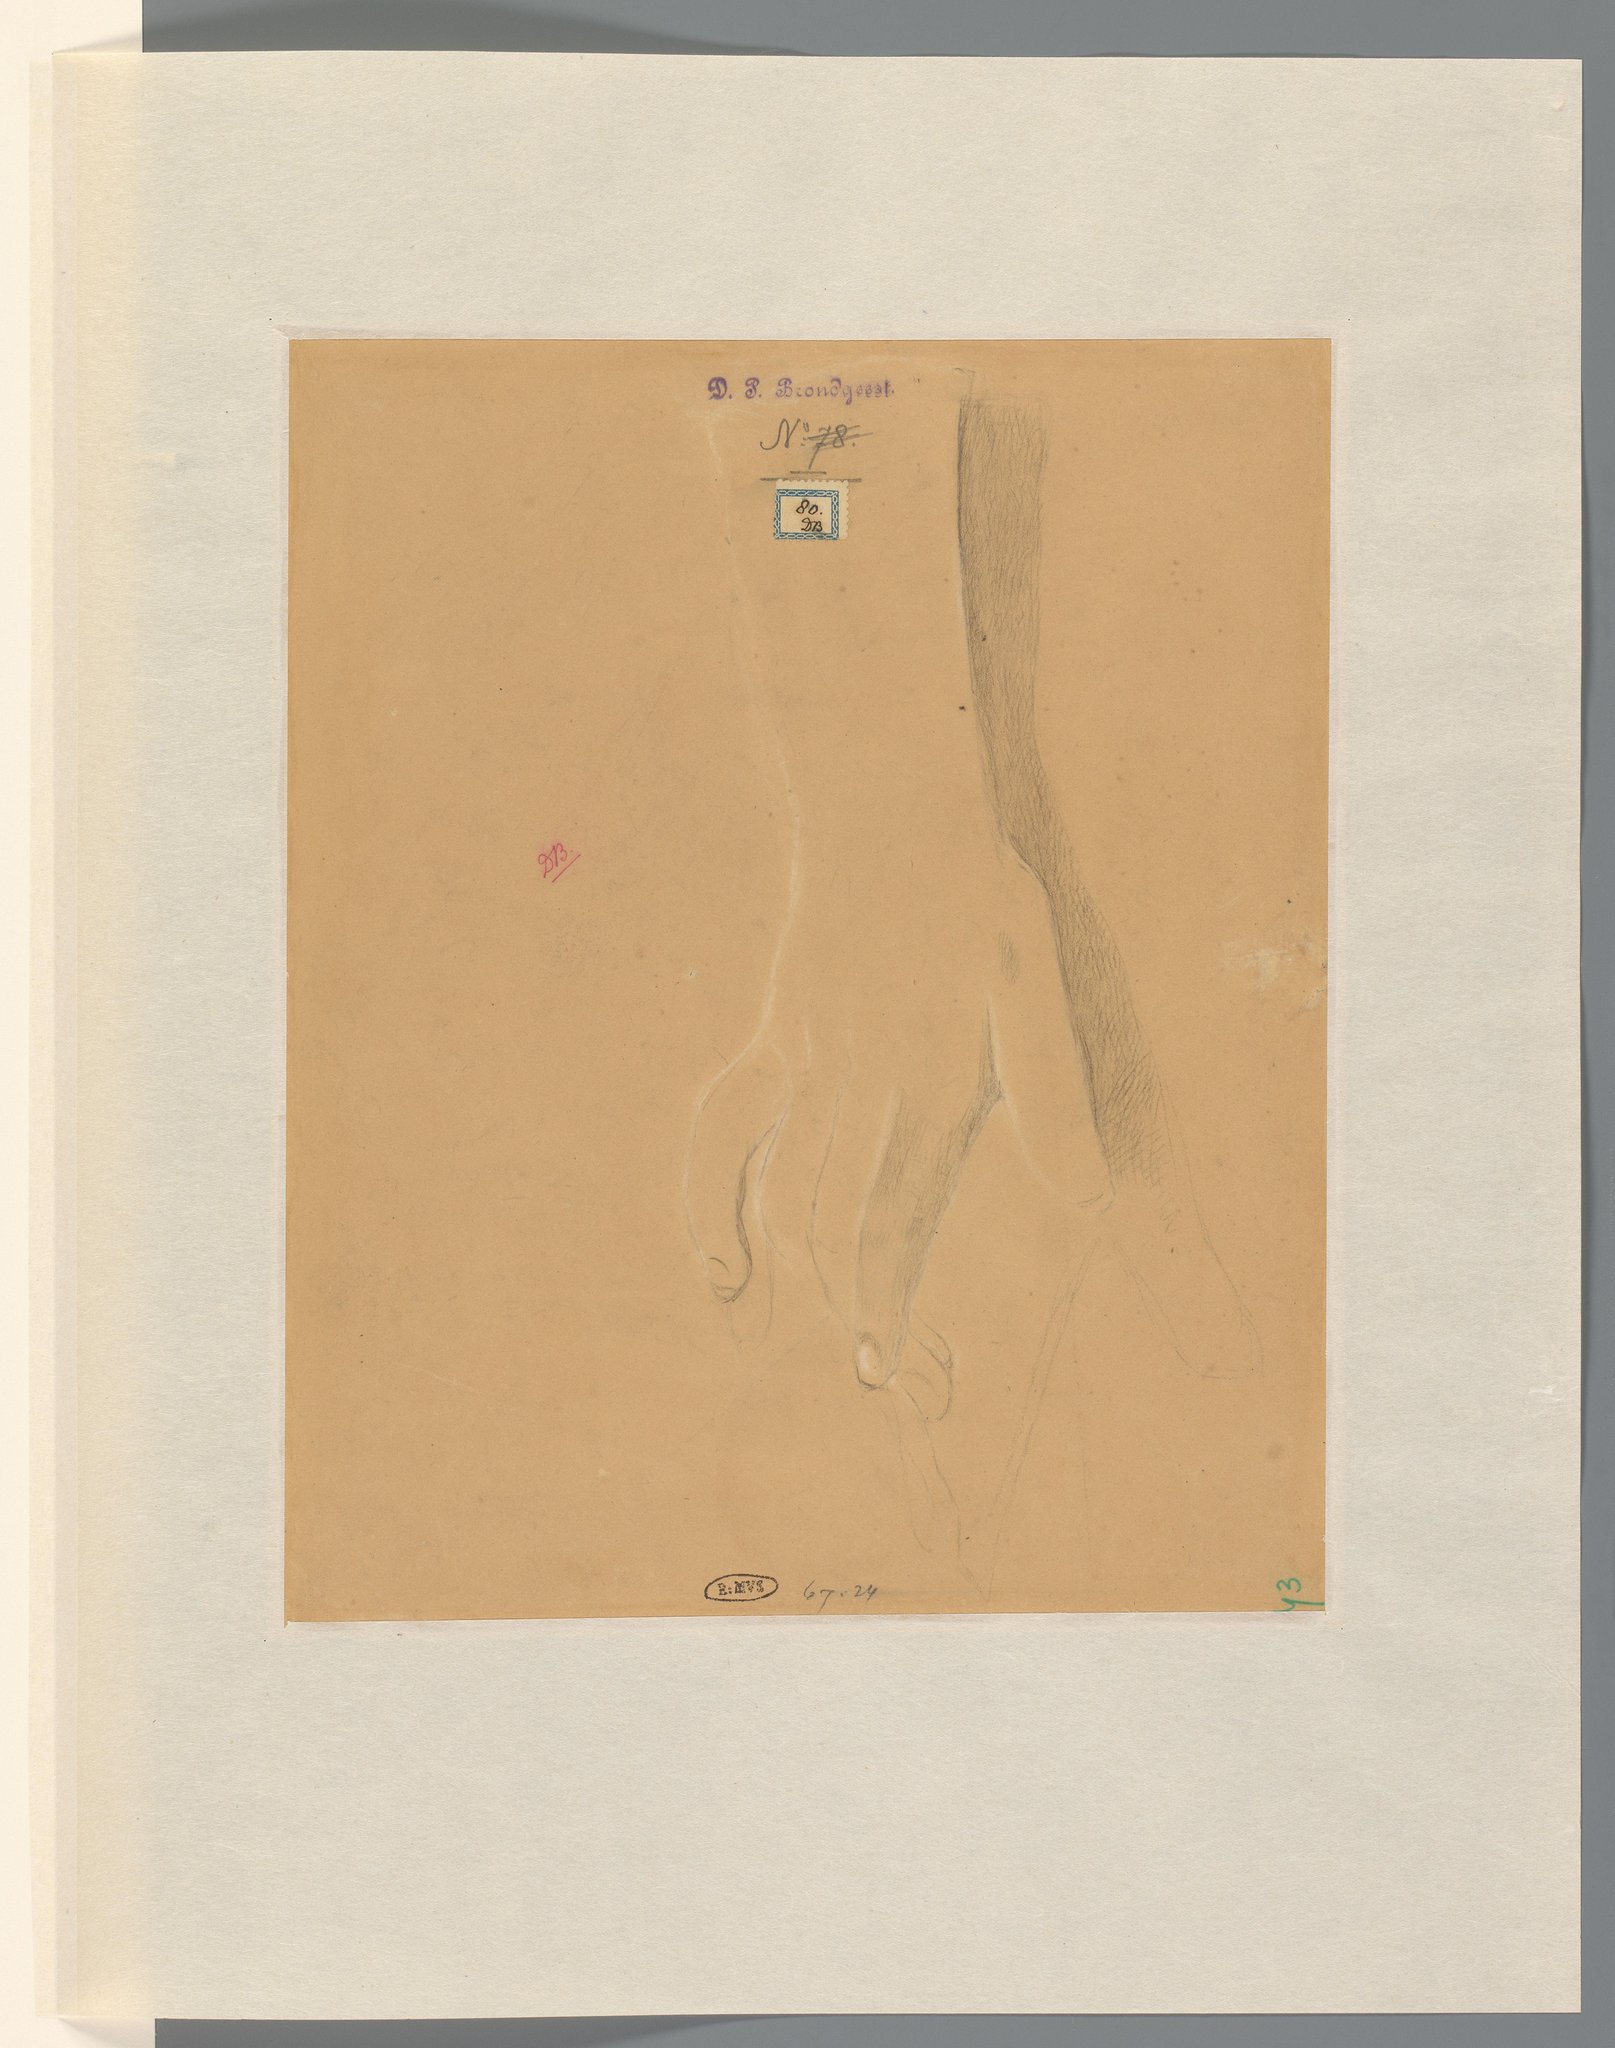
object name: drawing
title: Studie van een hand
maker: albertus brondgeest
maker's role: draughtsman, print maker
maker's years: 1786-1849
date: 1796-1849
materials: chalk, paper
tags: hand